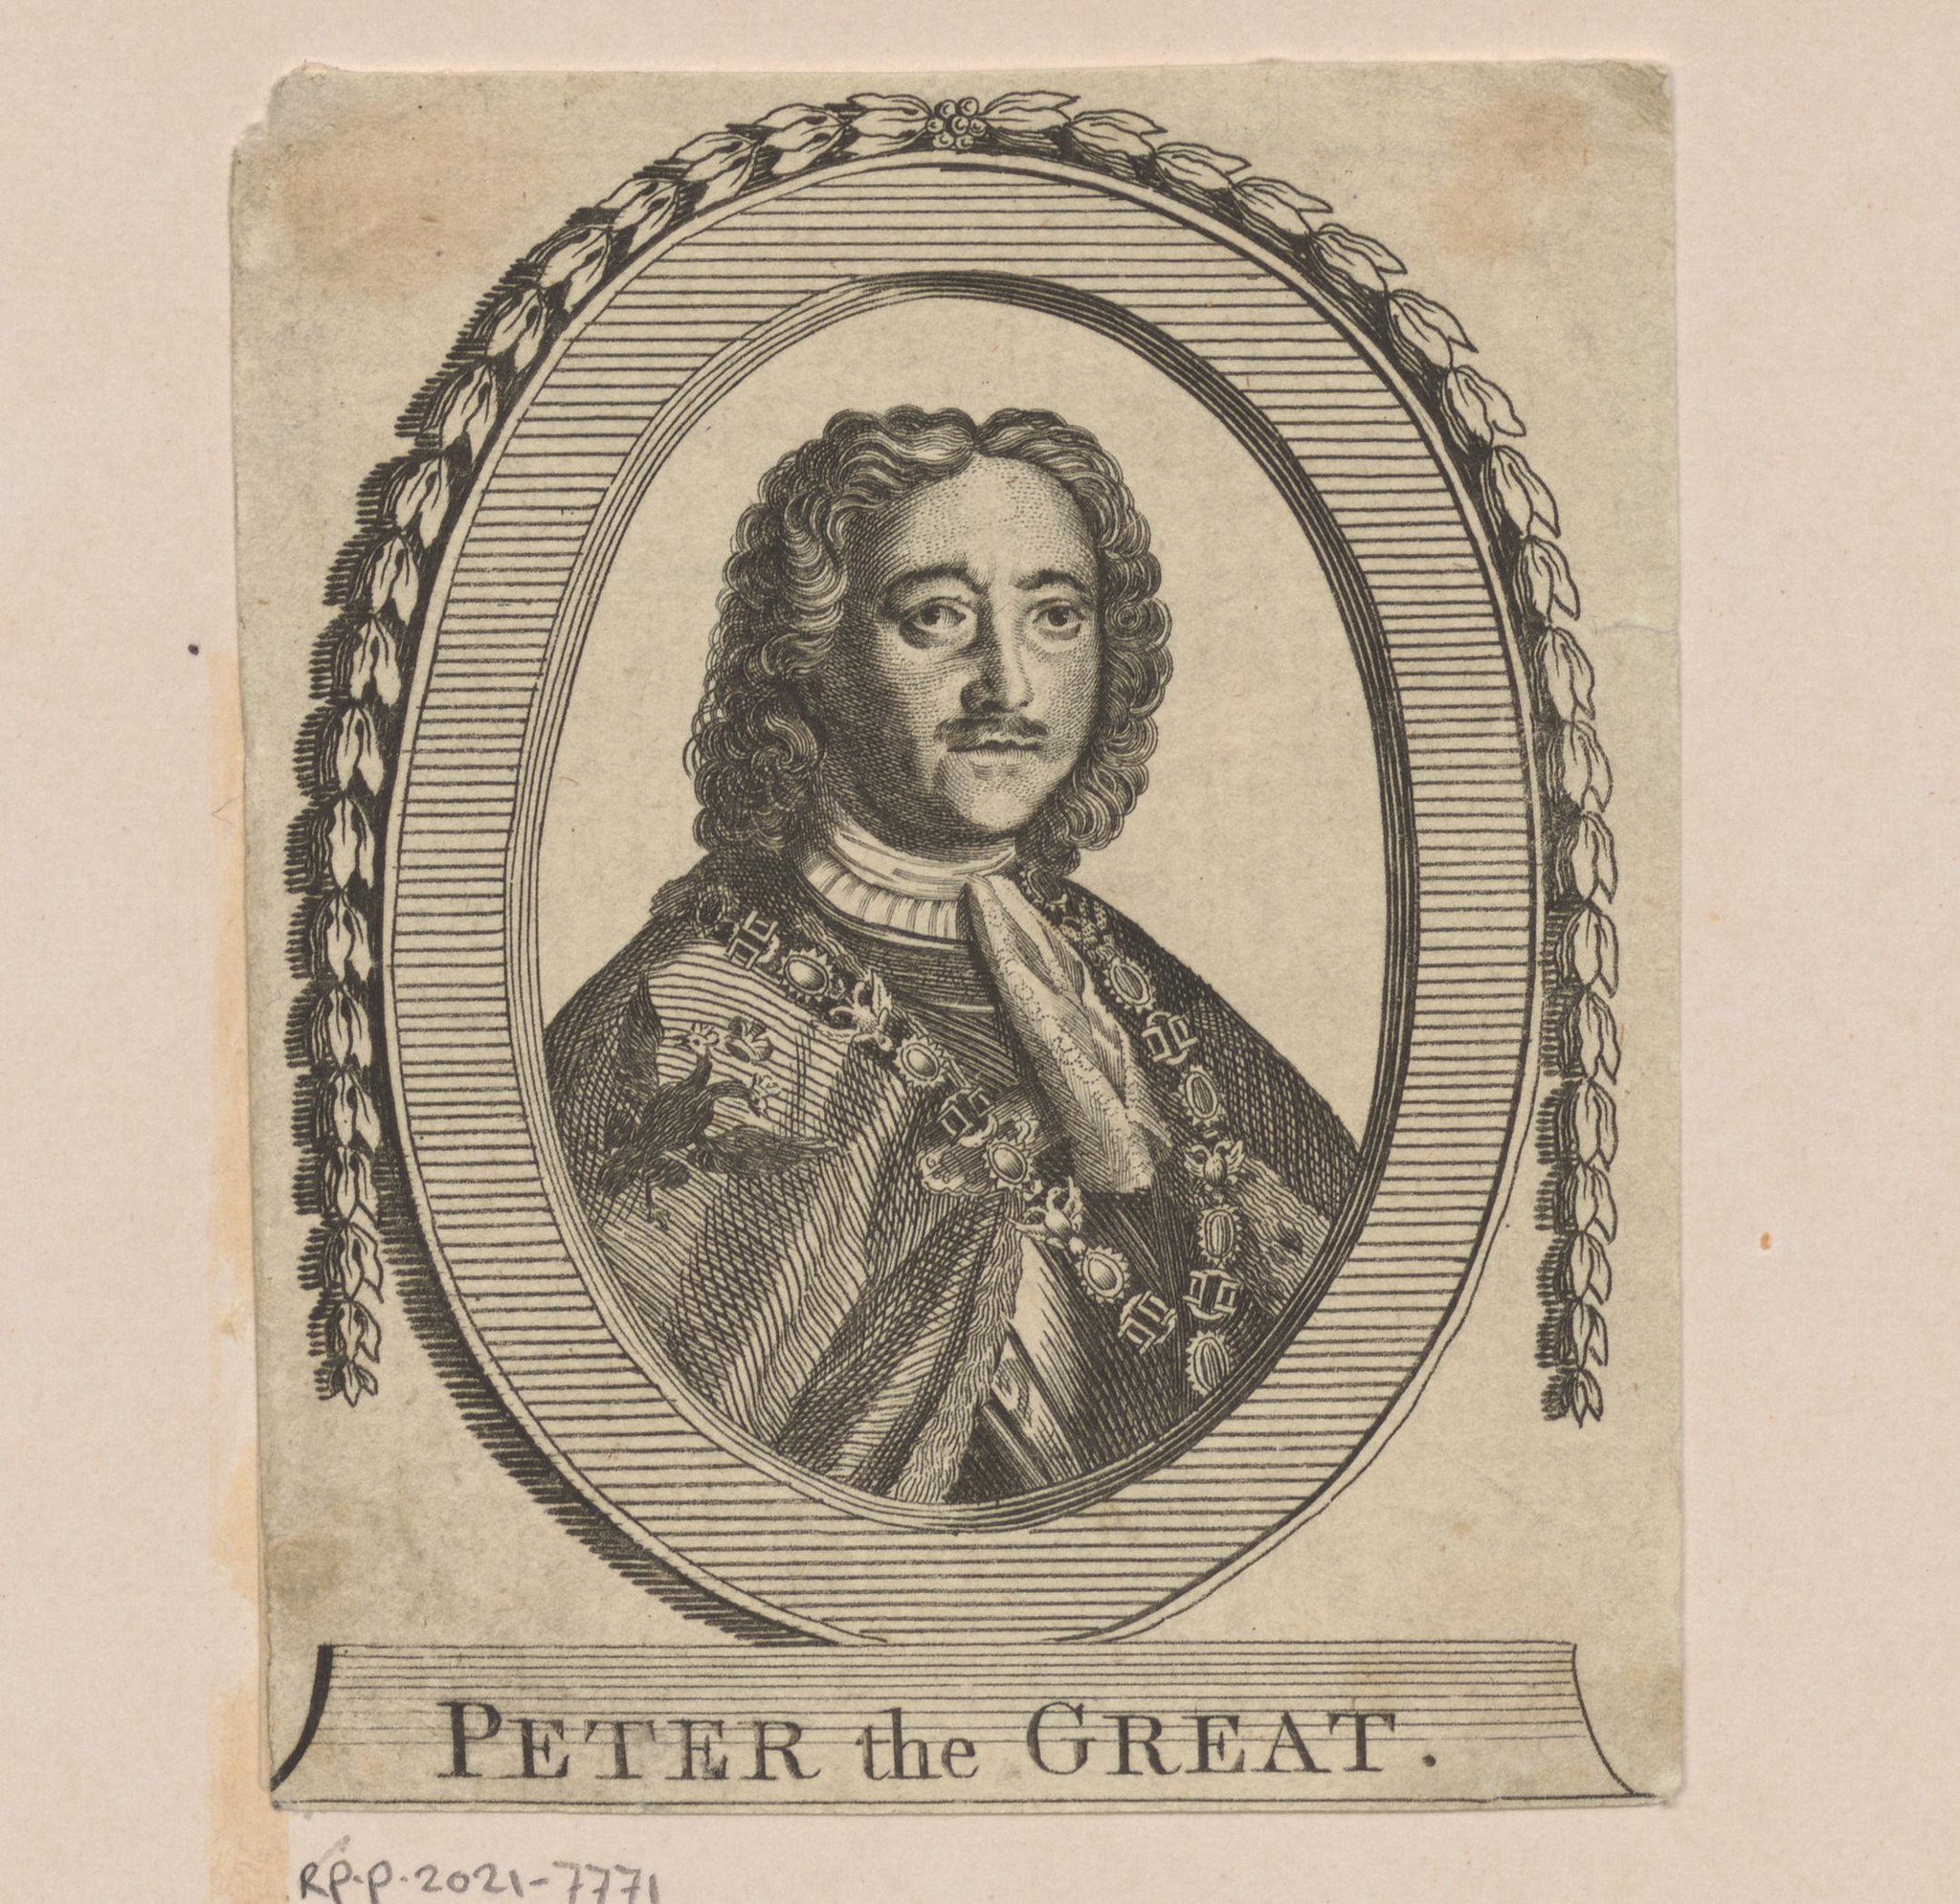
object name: print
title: Portret van Peter I de Grote, tsaar van Rusland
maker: Anonymous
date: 1700-1799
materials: paper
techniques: engraving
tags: peter i de grote (tsaar van rusland), adult man, historical persons